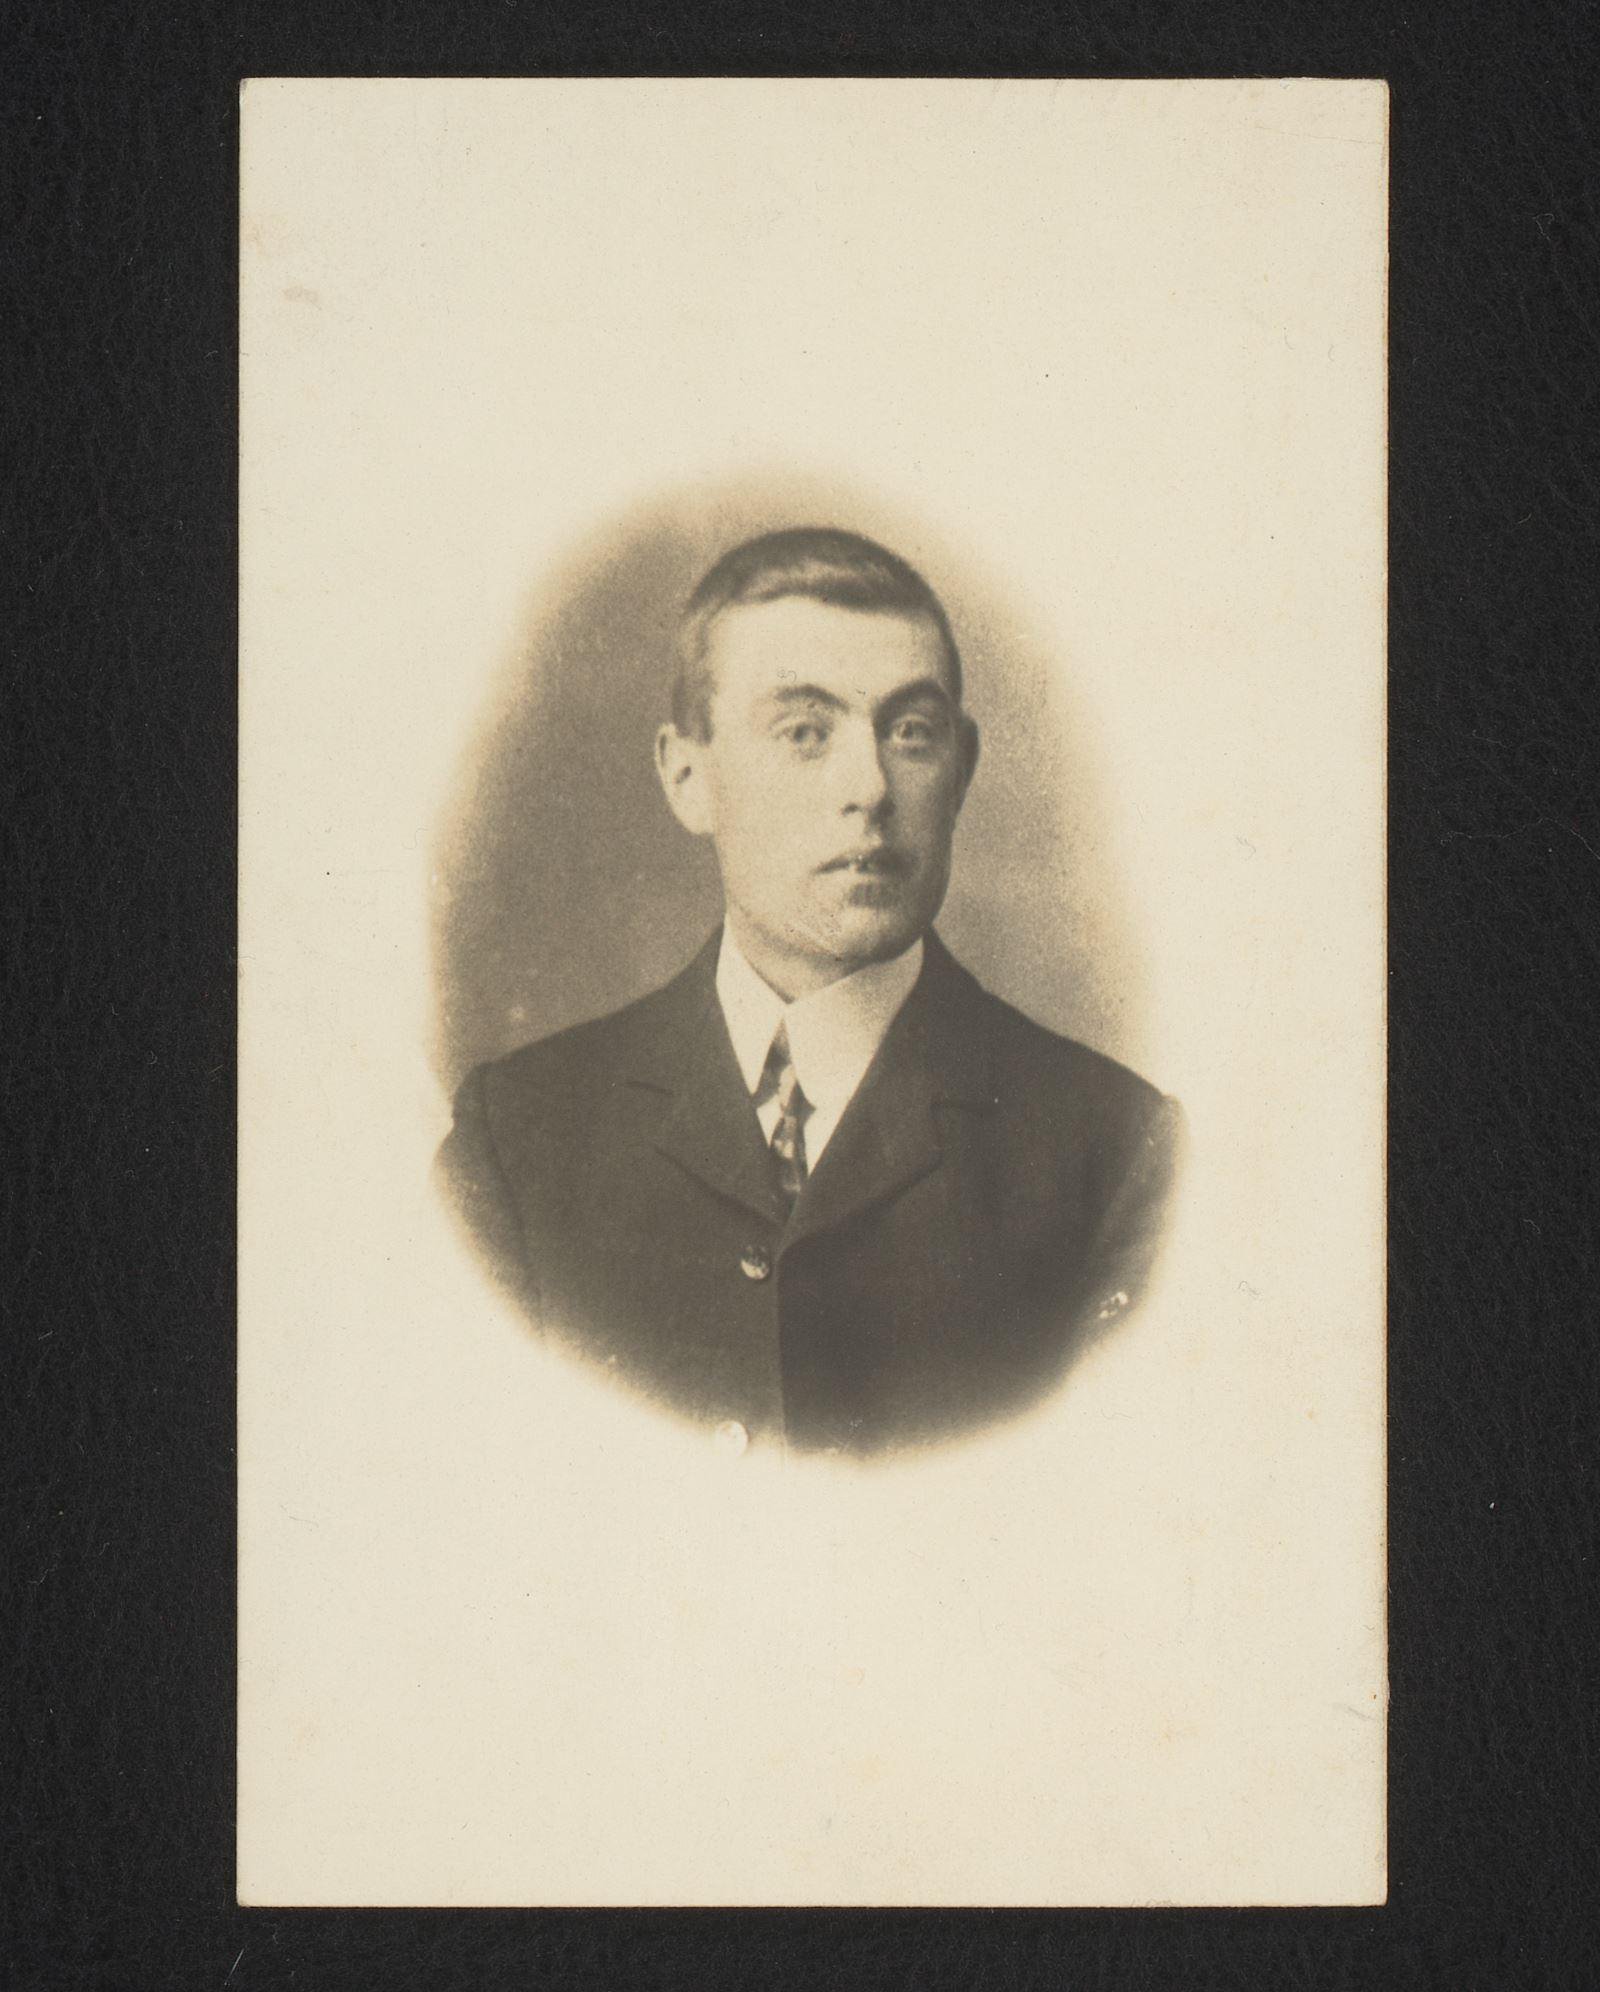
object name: album leaf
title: Portret van een man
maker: Anonymous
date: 1860-1900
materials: cardboard, photographic support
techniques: gelatin silver print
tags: adult man, historical persons